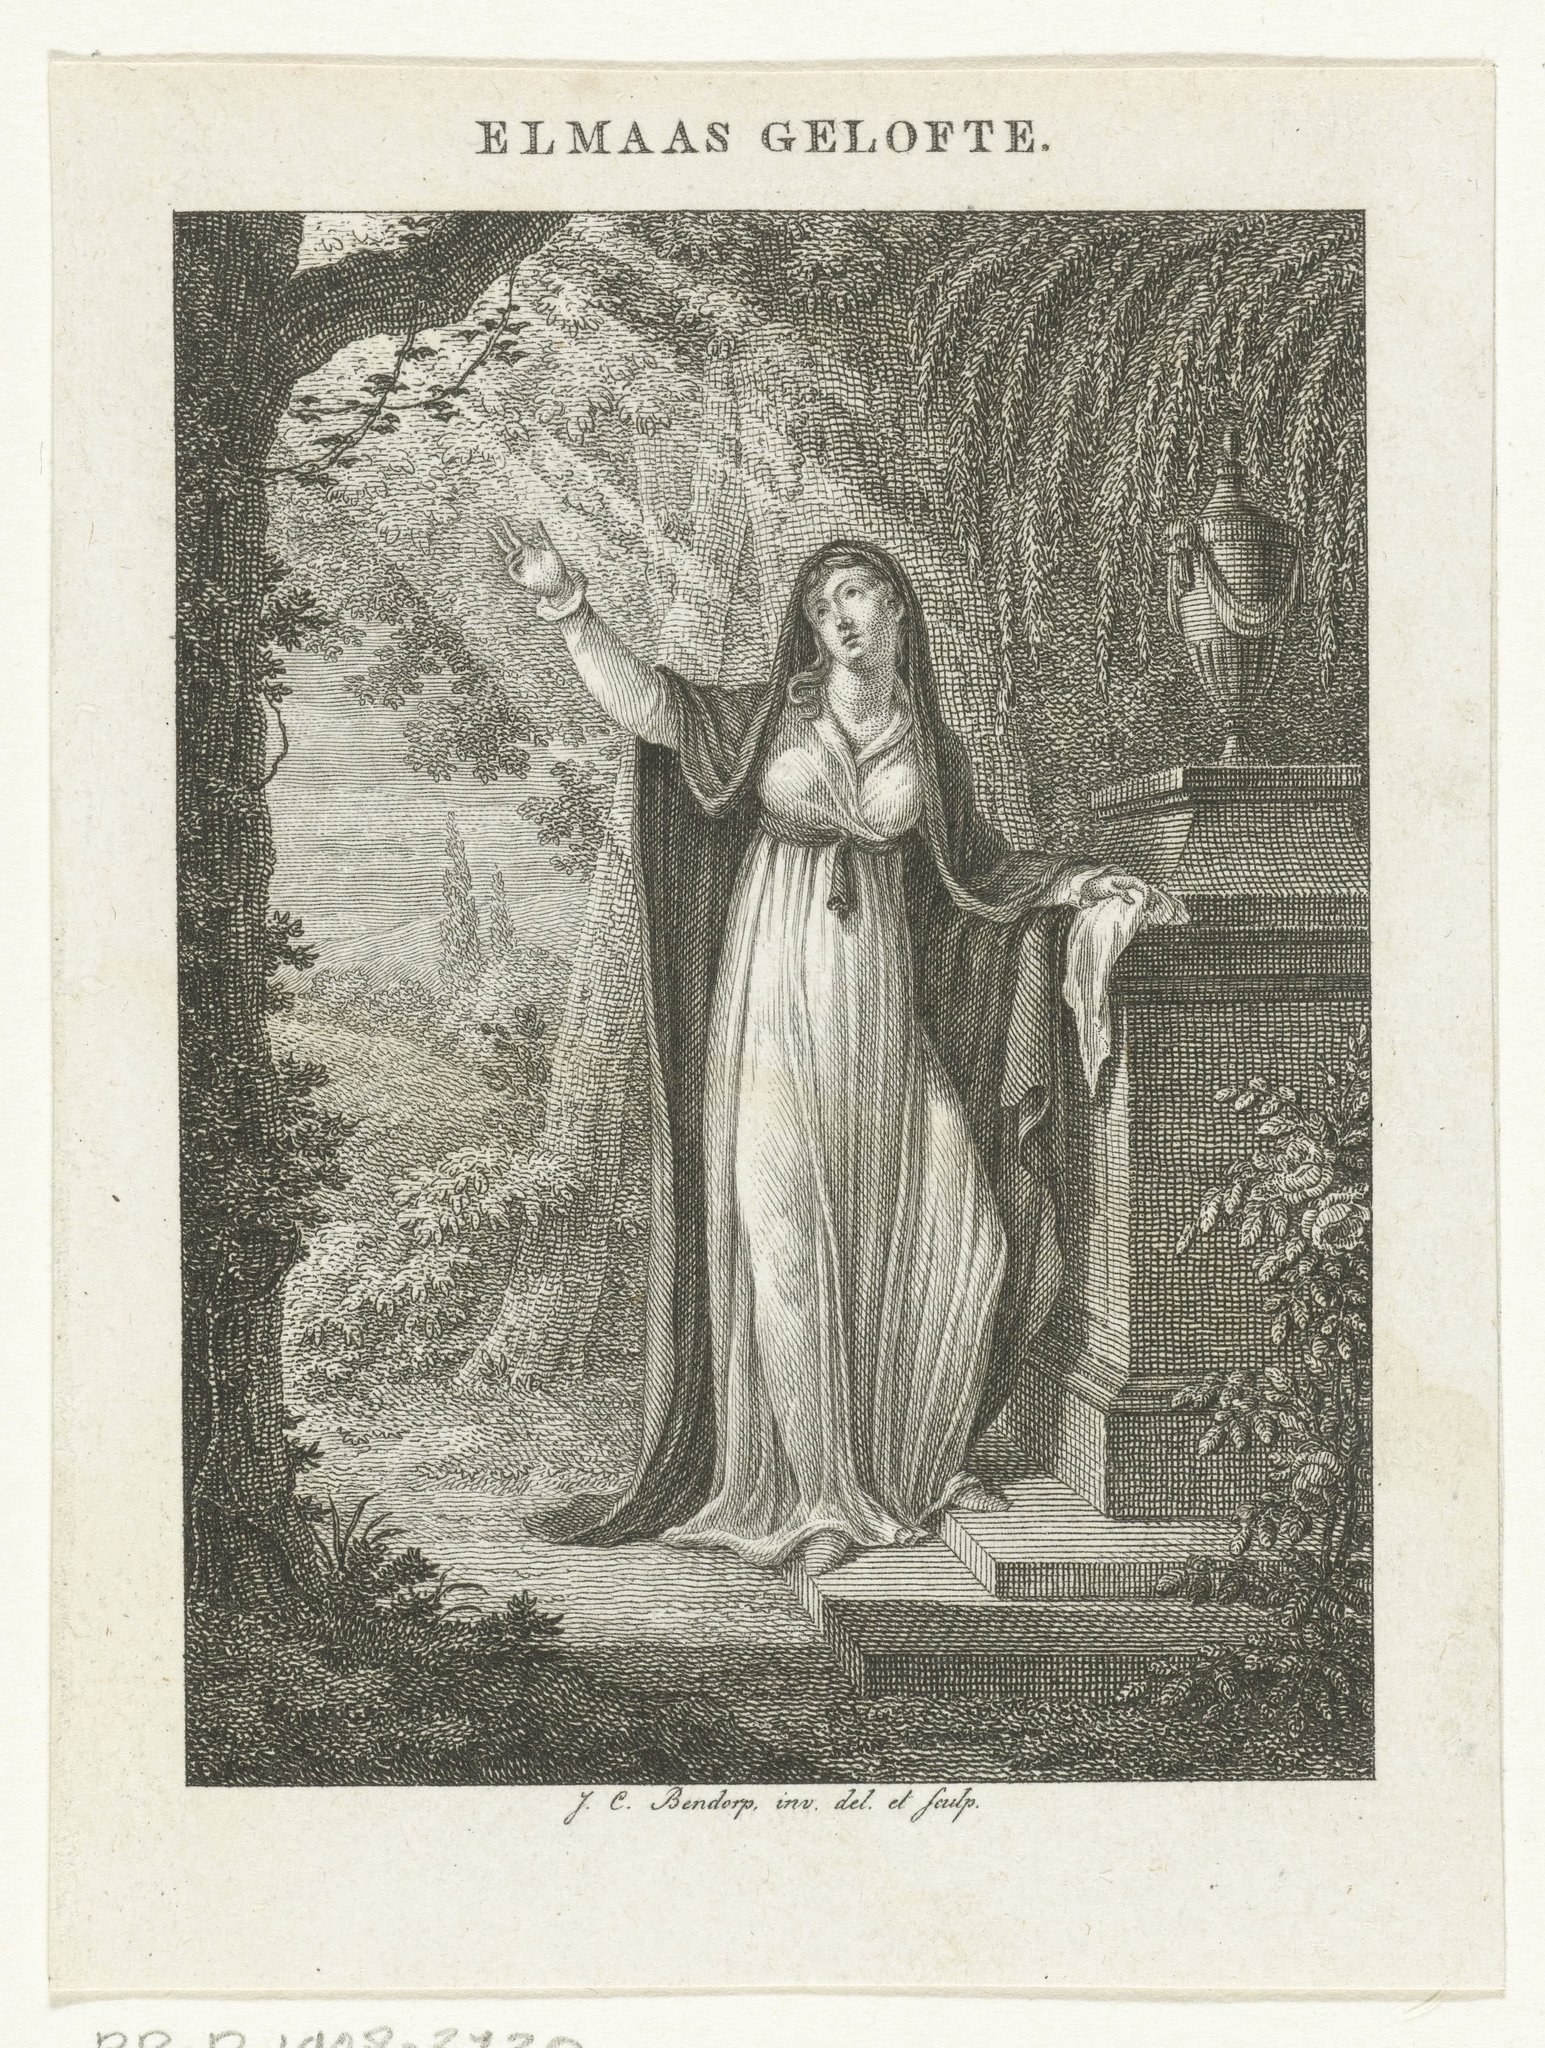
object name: book illustration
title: Elmaas gelofte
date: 1776-1822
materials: paper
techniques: etching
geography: netherlands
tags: grave, tomb, mourning the dead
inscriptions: collector's mark: Lugt 2228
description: Prent uit: Nederlandsche muzen-almanak, Johannes Immerzeel (uitgever), Rotterdam 1822. Illustratie bij gedicht Elmaas gelofte van Jan Schouten.